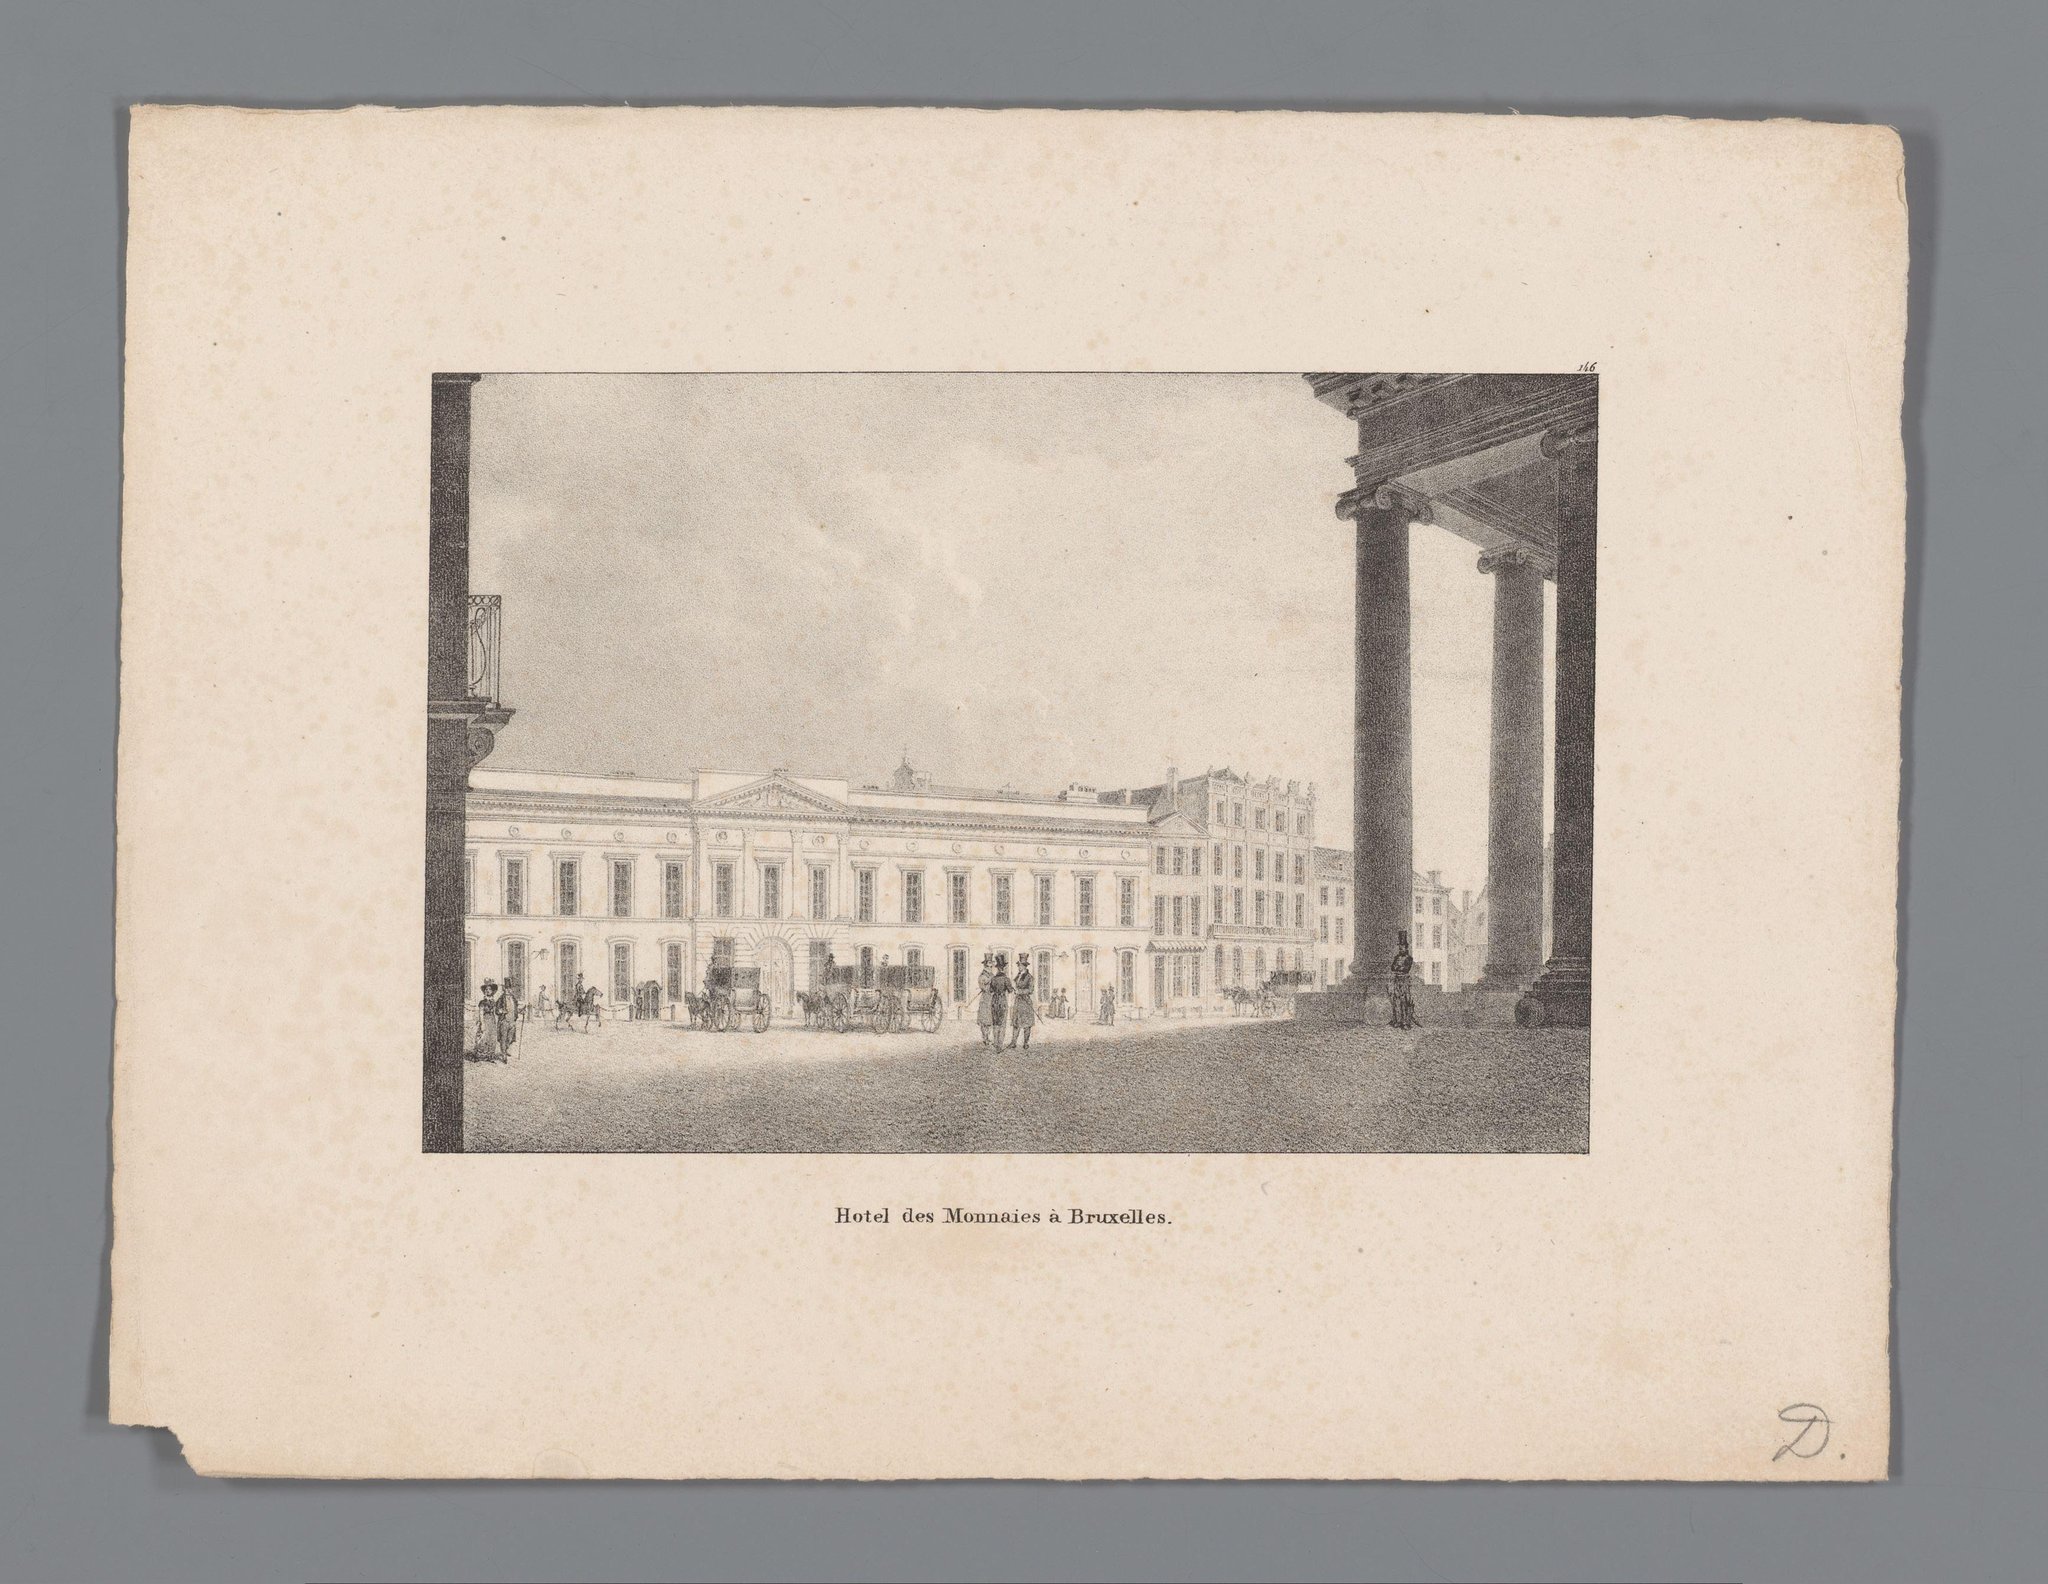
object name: print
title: Gezicht op Brussel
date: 1802-1861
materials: paper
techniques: lithograph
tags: city-view, and landscape with man-made constructions, brussels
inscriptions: collector's mark: Lugt 2233